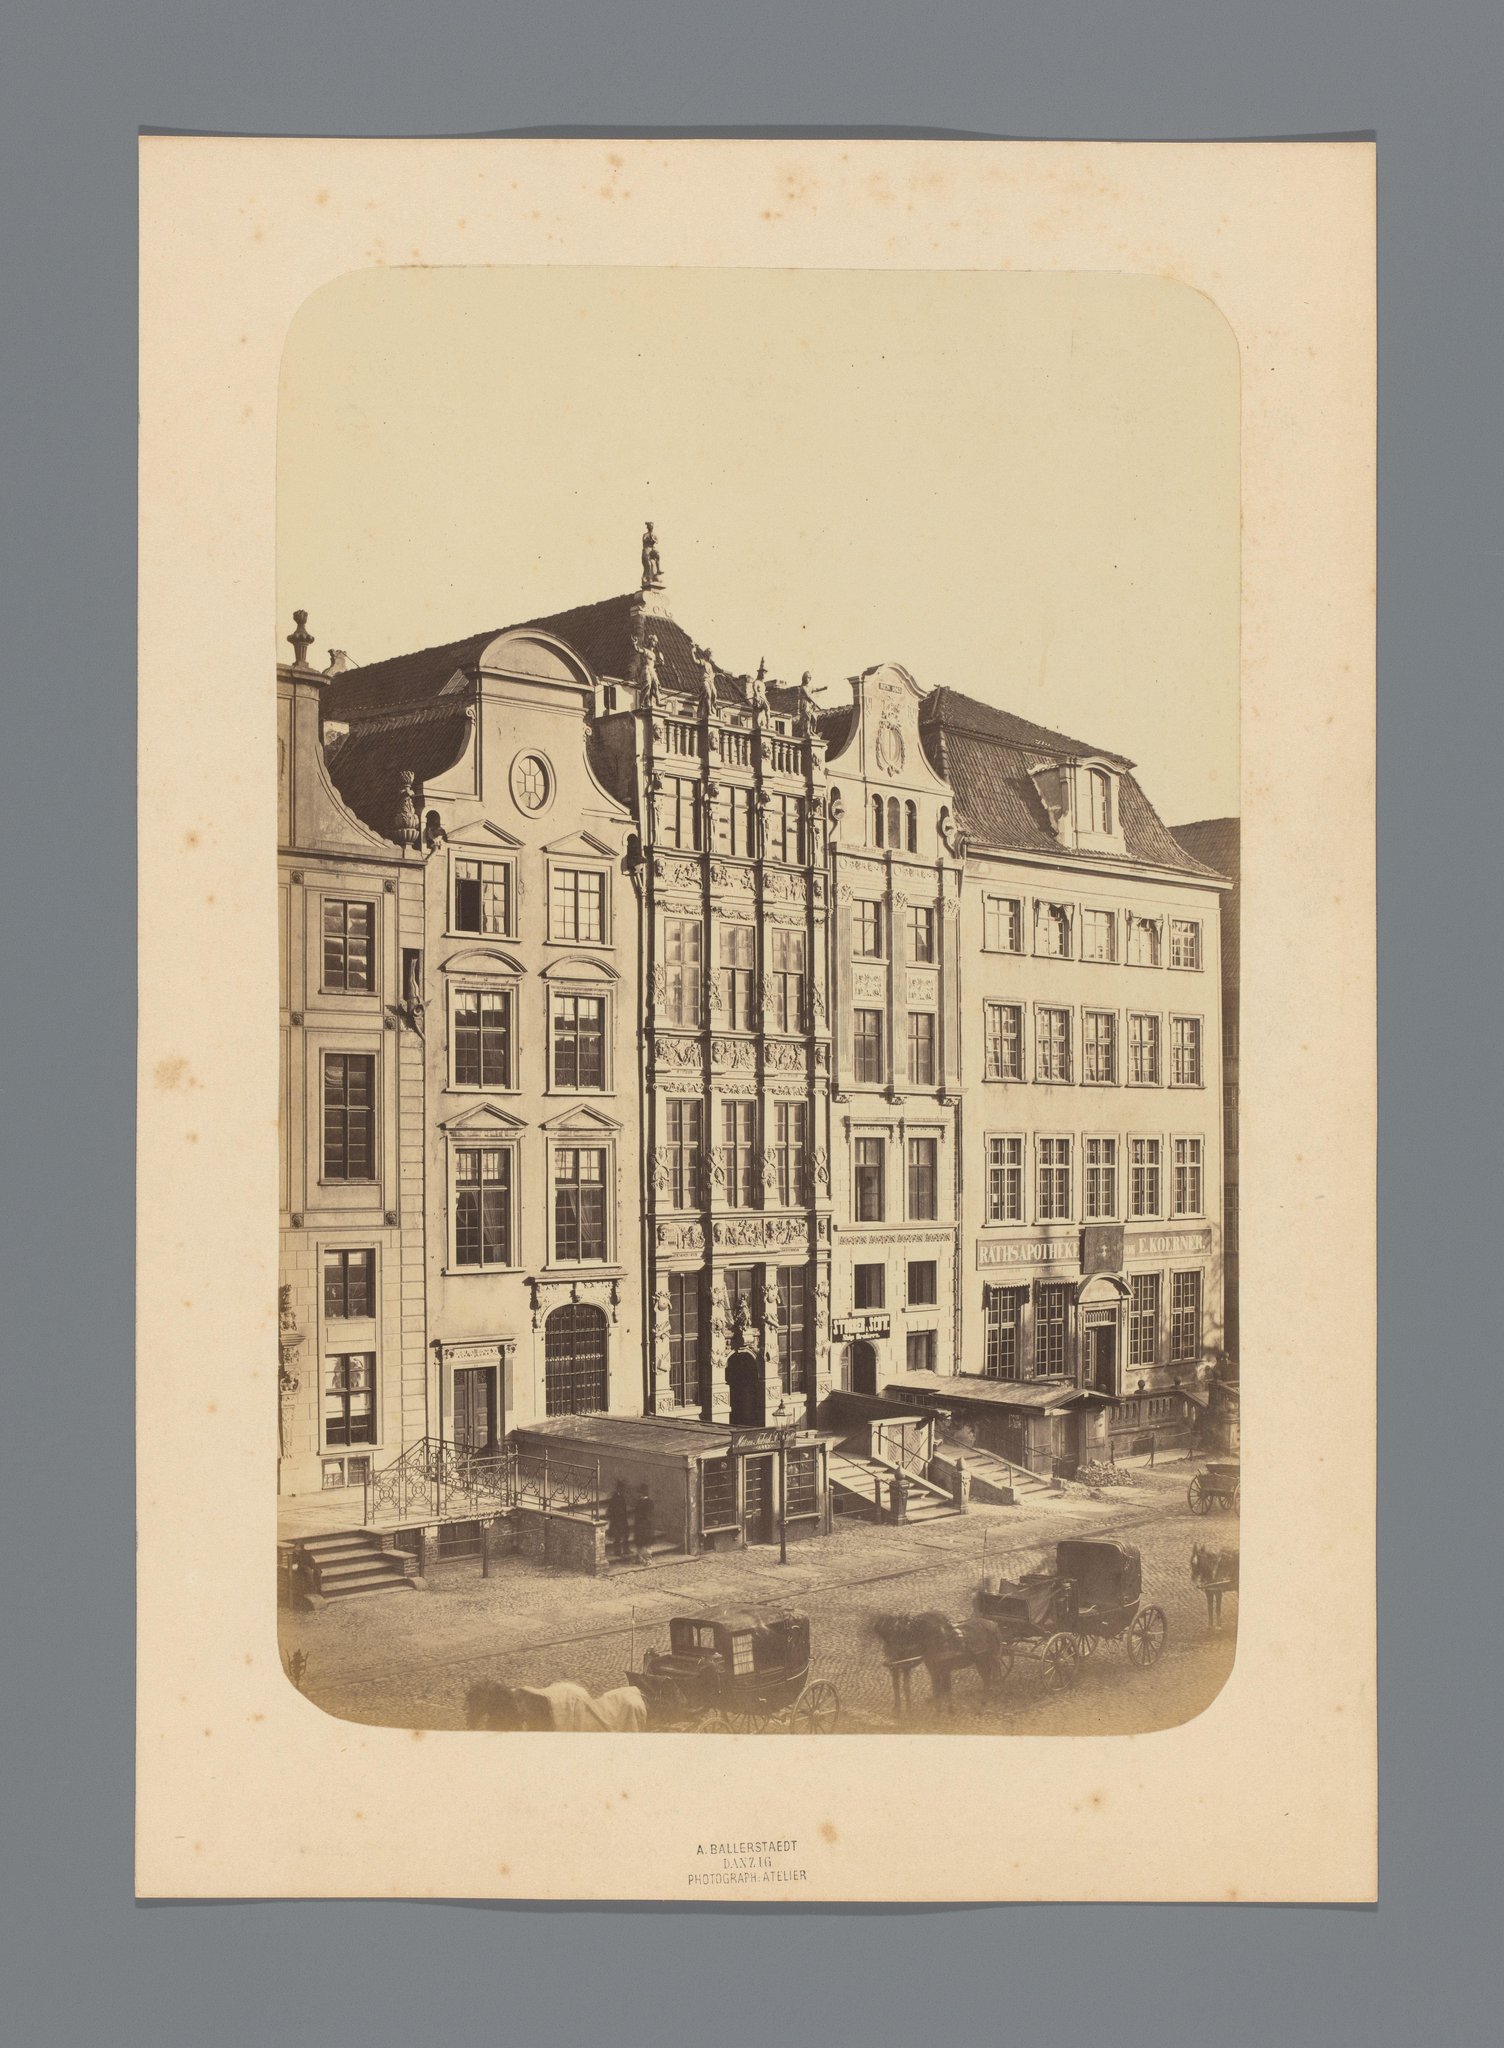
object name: photograph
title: Danzig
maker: albert ballerstaedt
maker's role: fotograaf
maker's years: 1833-1877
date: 1850-1877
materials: cardboard, photographic support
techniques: albumen print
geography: danzig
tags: danzig